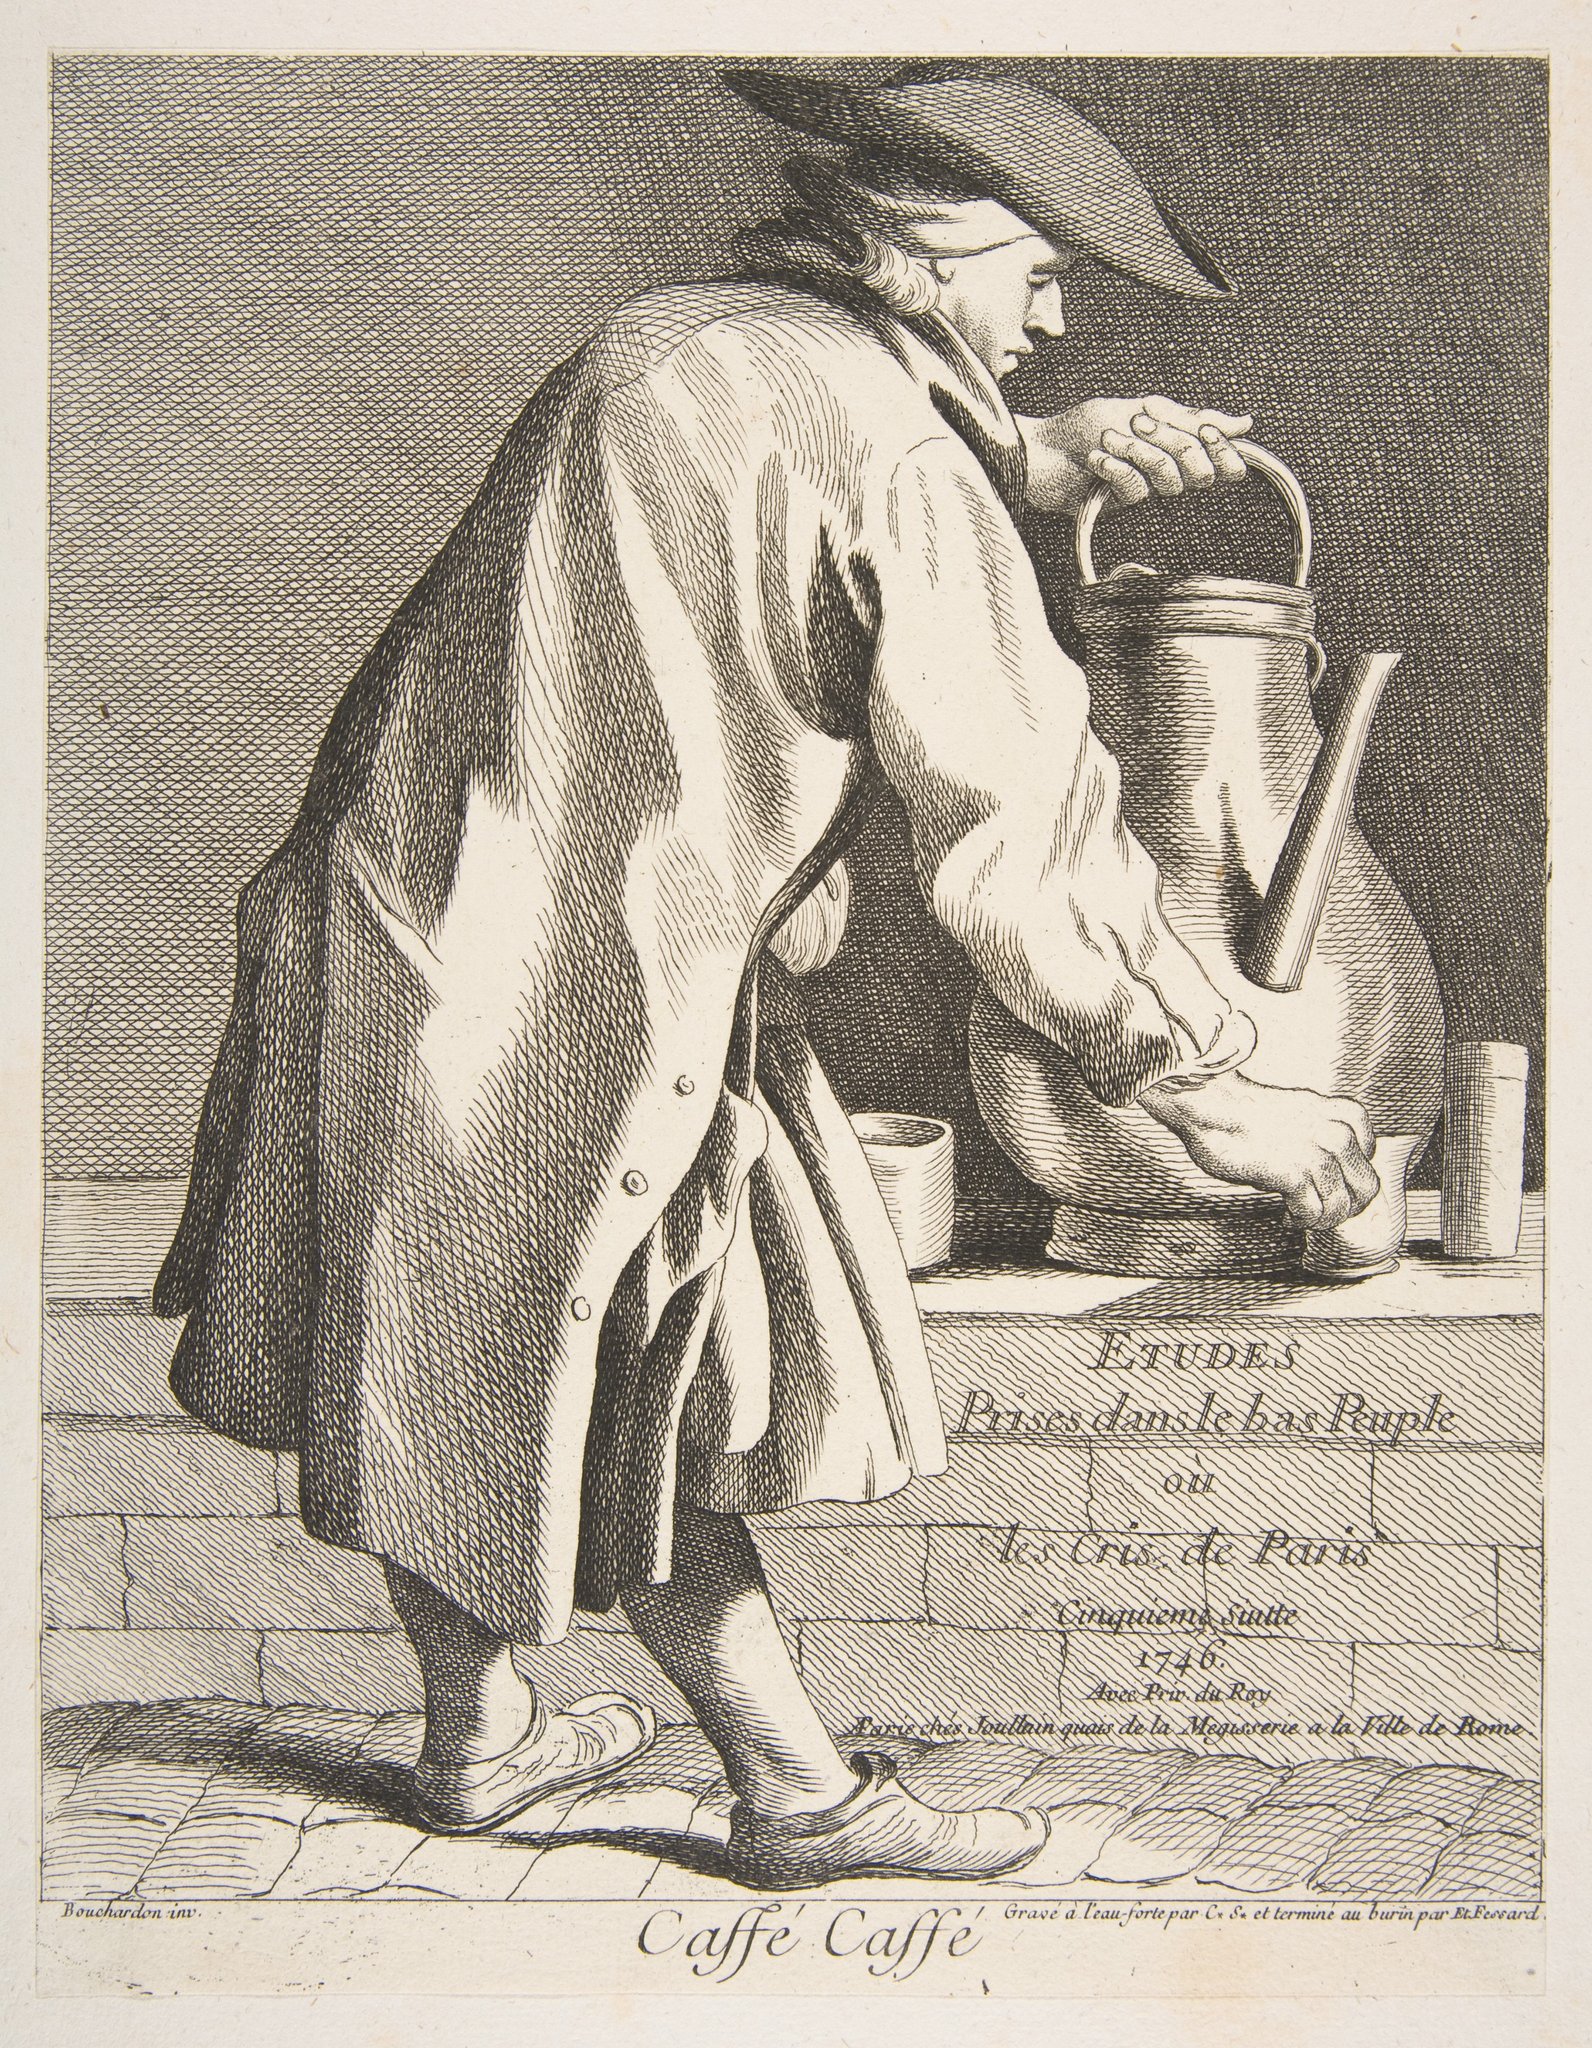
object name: print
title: Coffee Vendor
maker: anne claude philippe de tubières, comte de caylus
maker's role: artist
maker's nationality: french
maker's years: 1692-1765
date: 1746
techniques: engraving, etching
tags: men,coffee